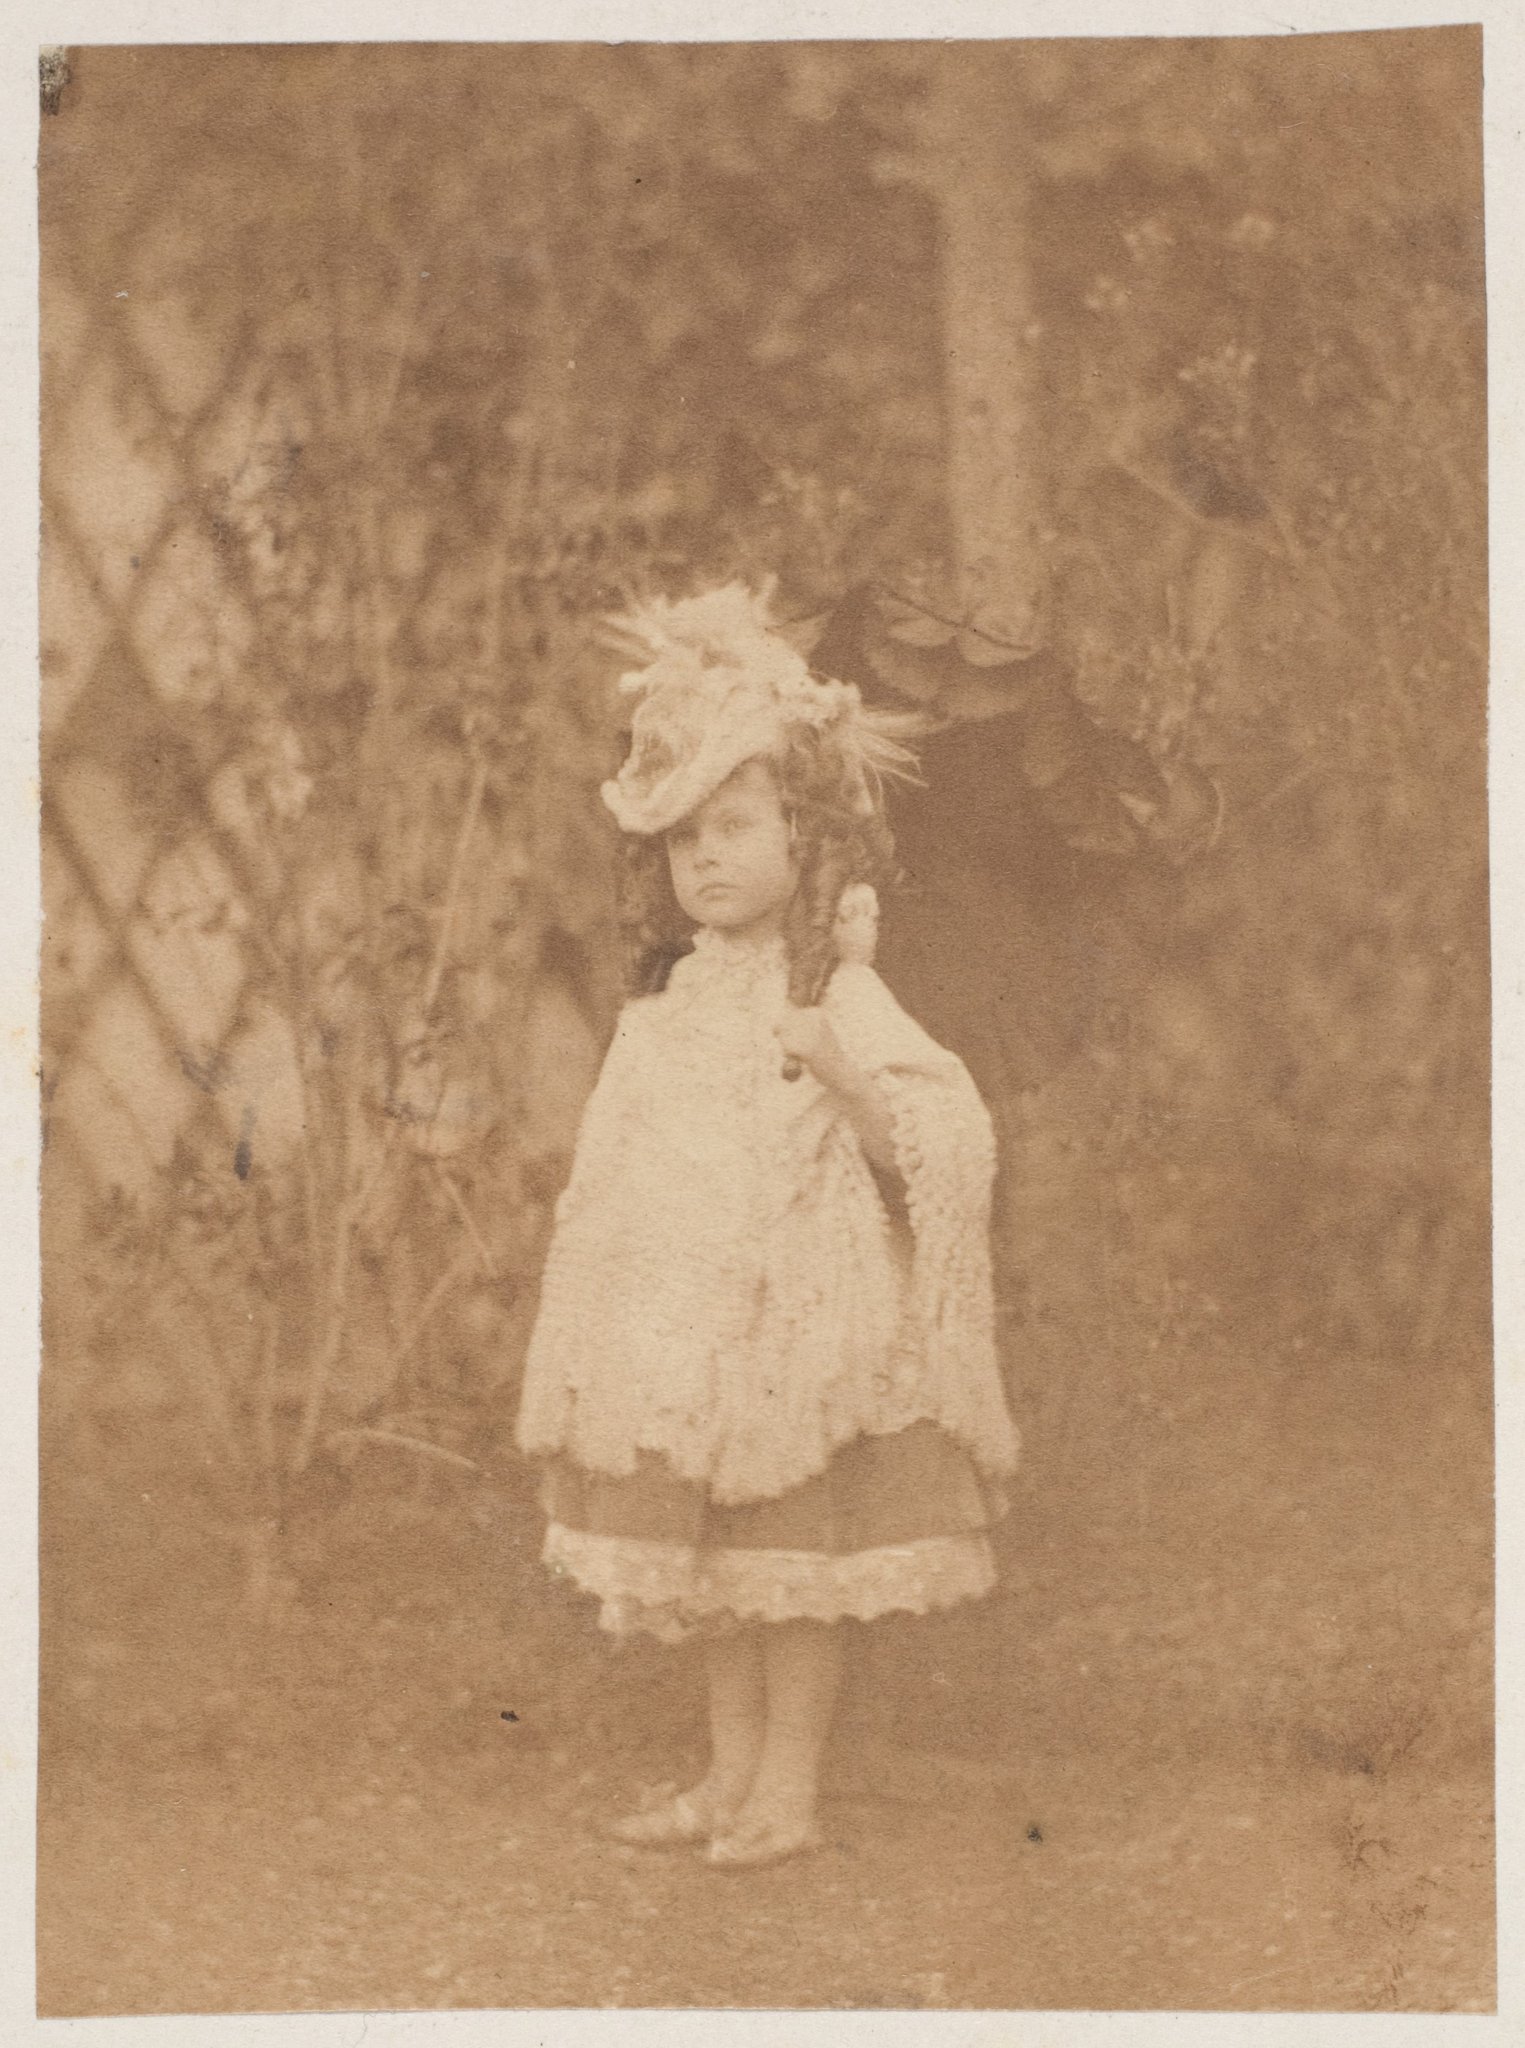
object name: photograph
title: Le treillage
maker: pierre-louis pierson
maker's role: artist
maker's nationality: french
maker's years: 1822-1913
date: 1860-1869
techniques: albumen silver print, glass negative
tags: girls,portraits